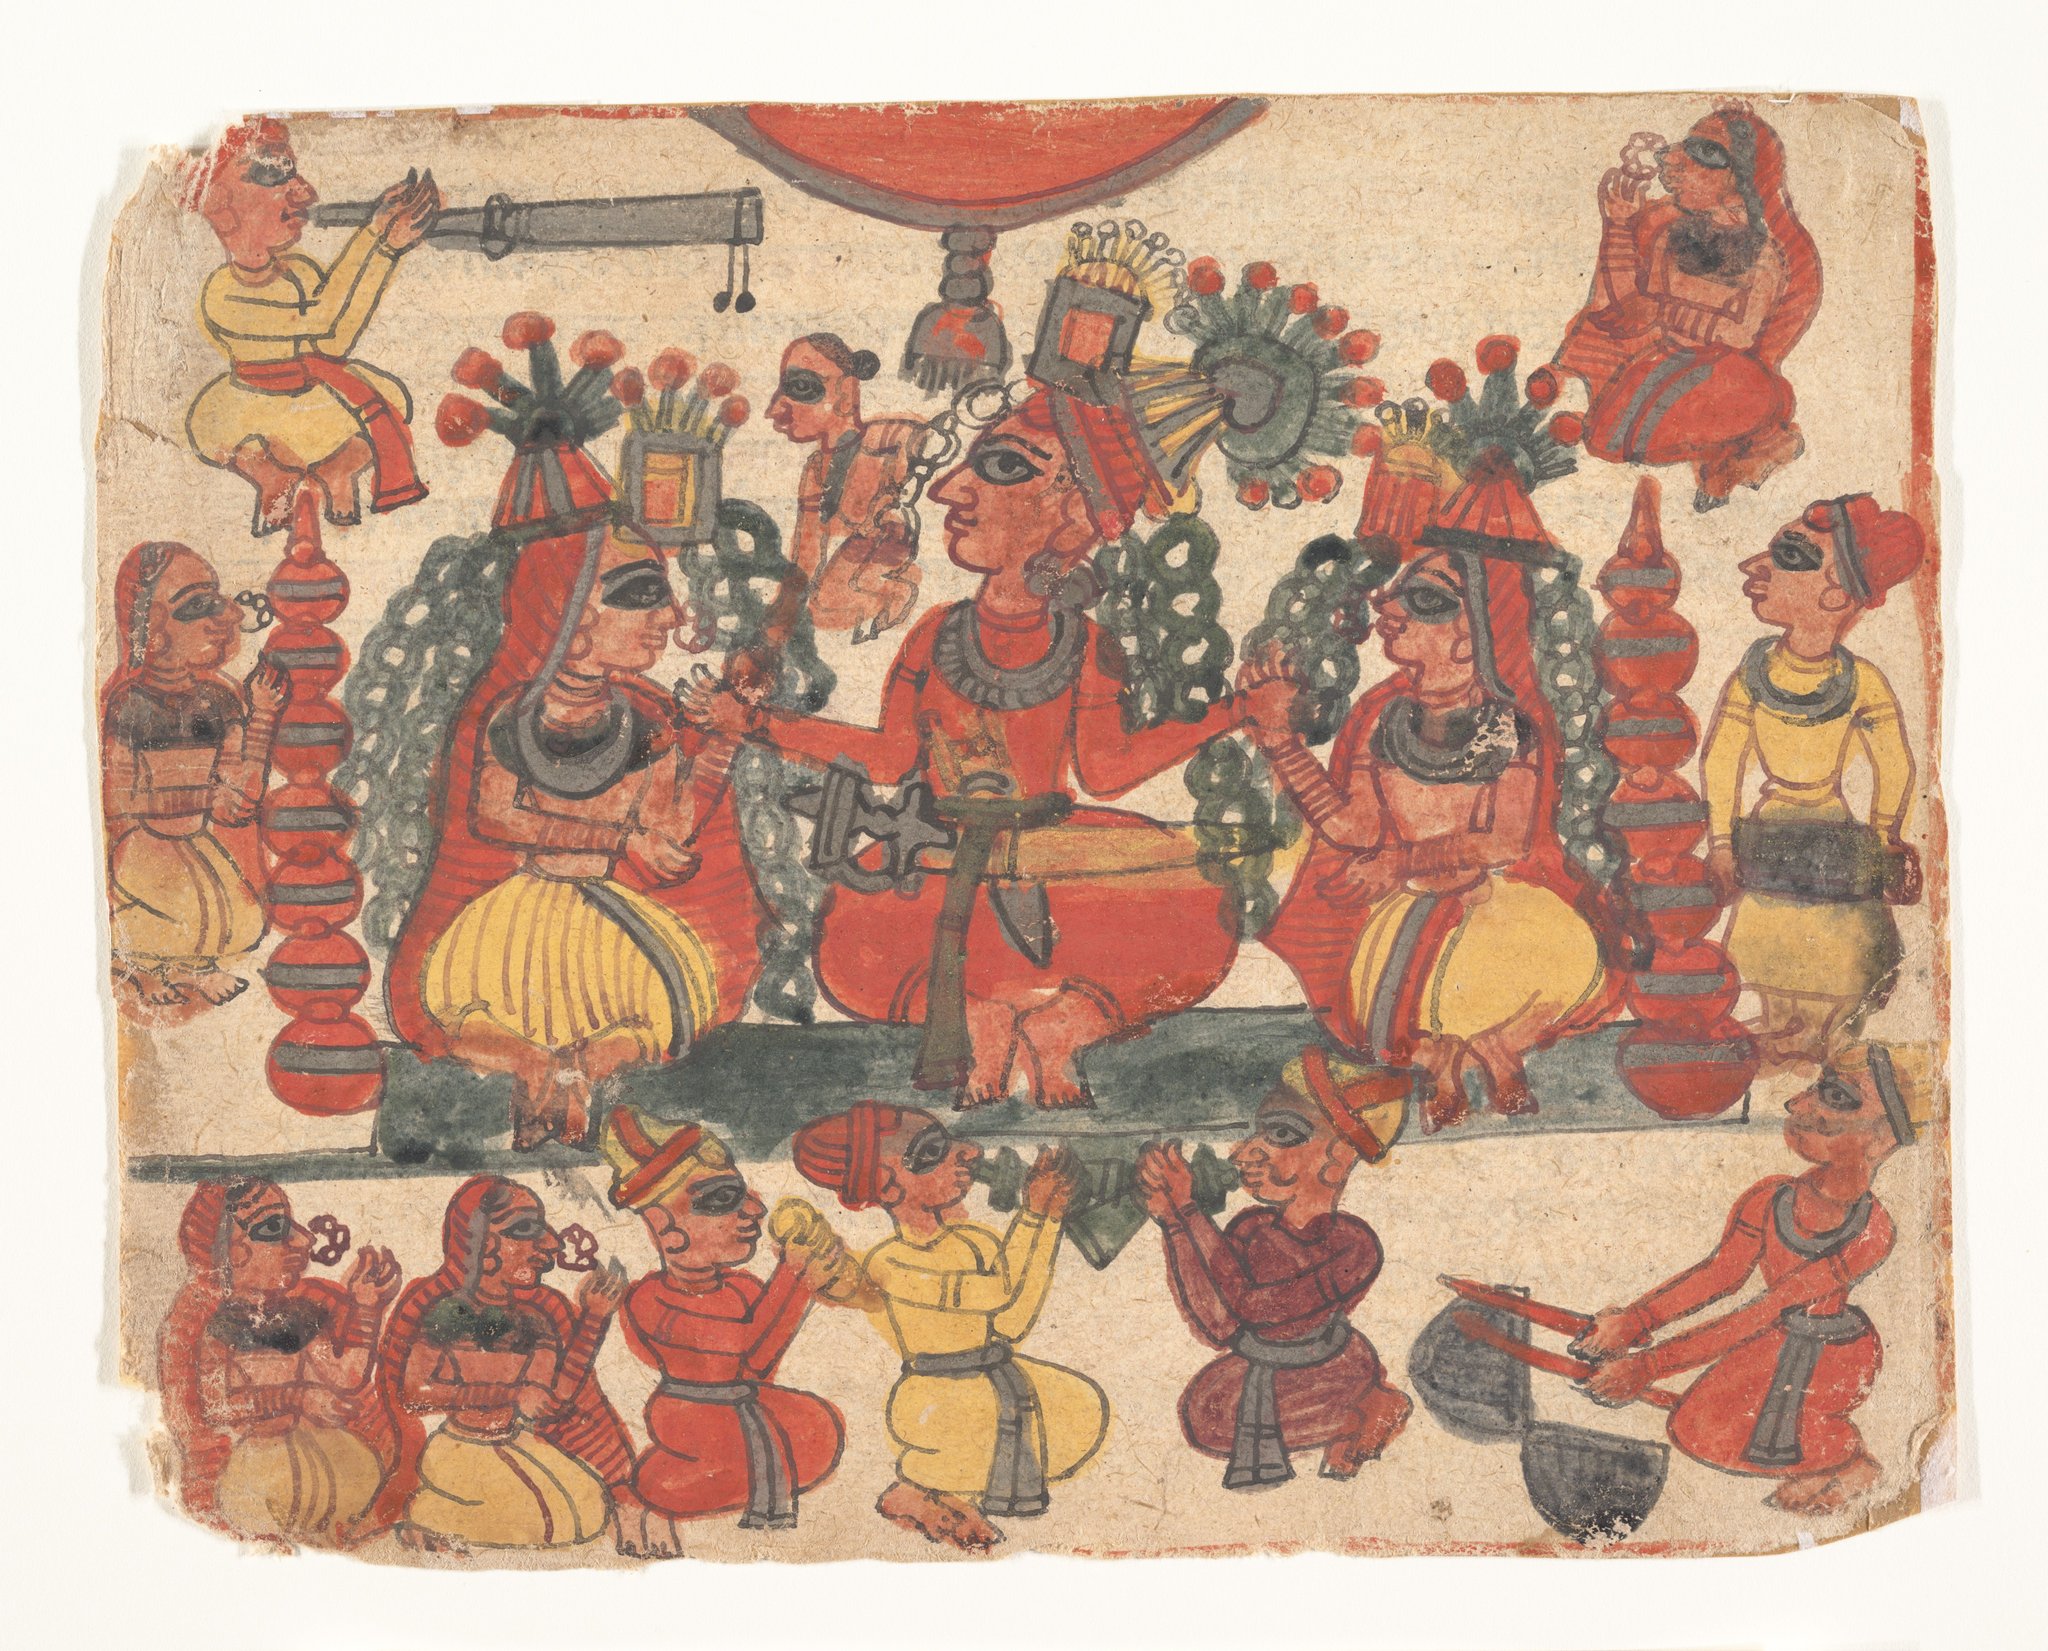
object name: folio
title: A Wedding Scene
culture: indian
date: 1734-1766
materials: ink, paper, watercolor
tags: musical instruments,men,women,weddings